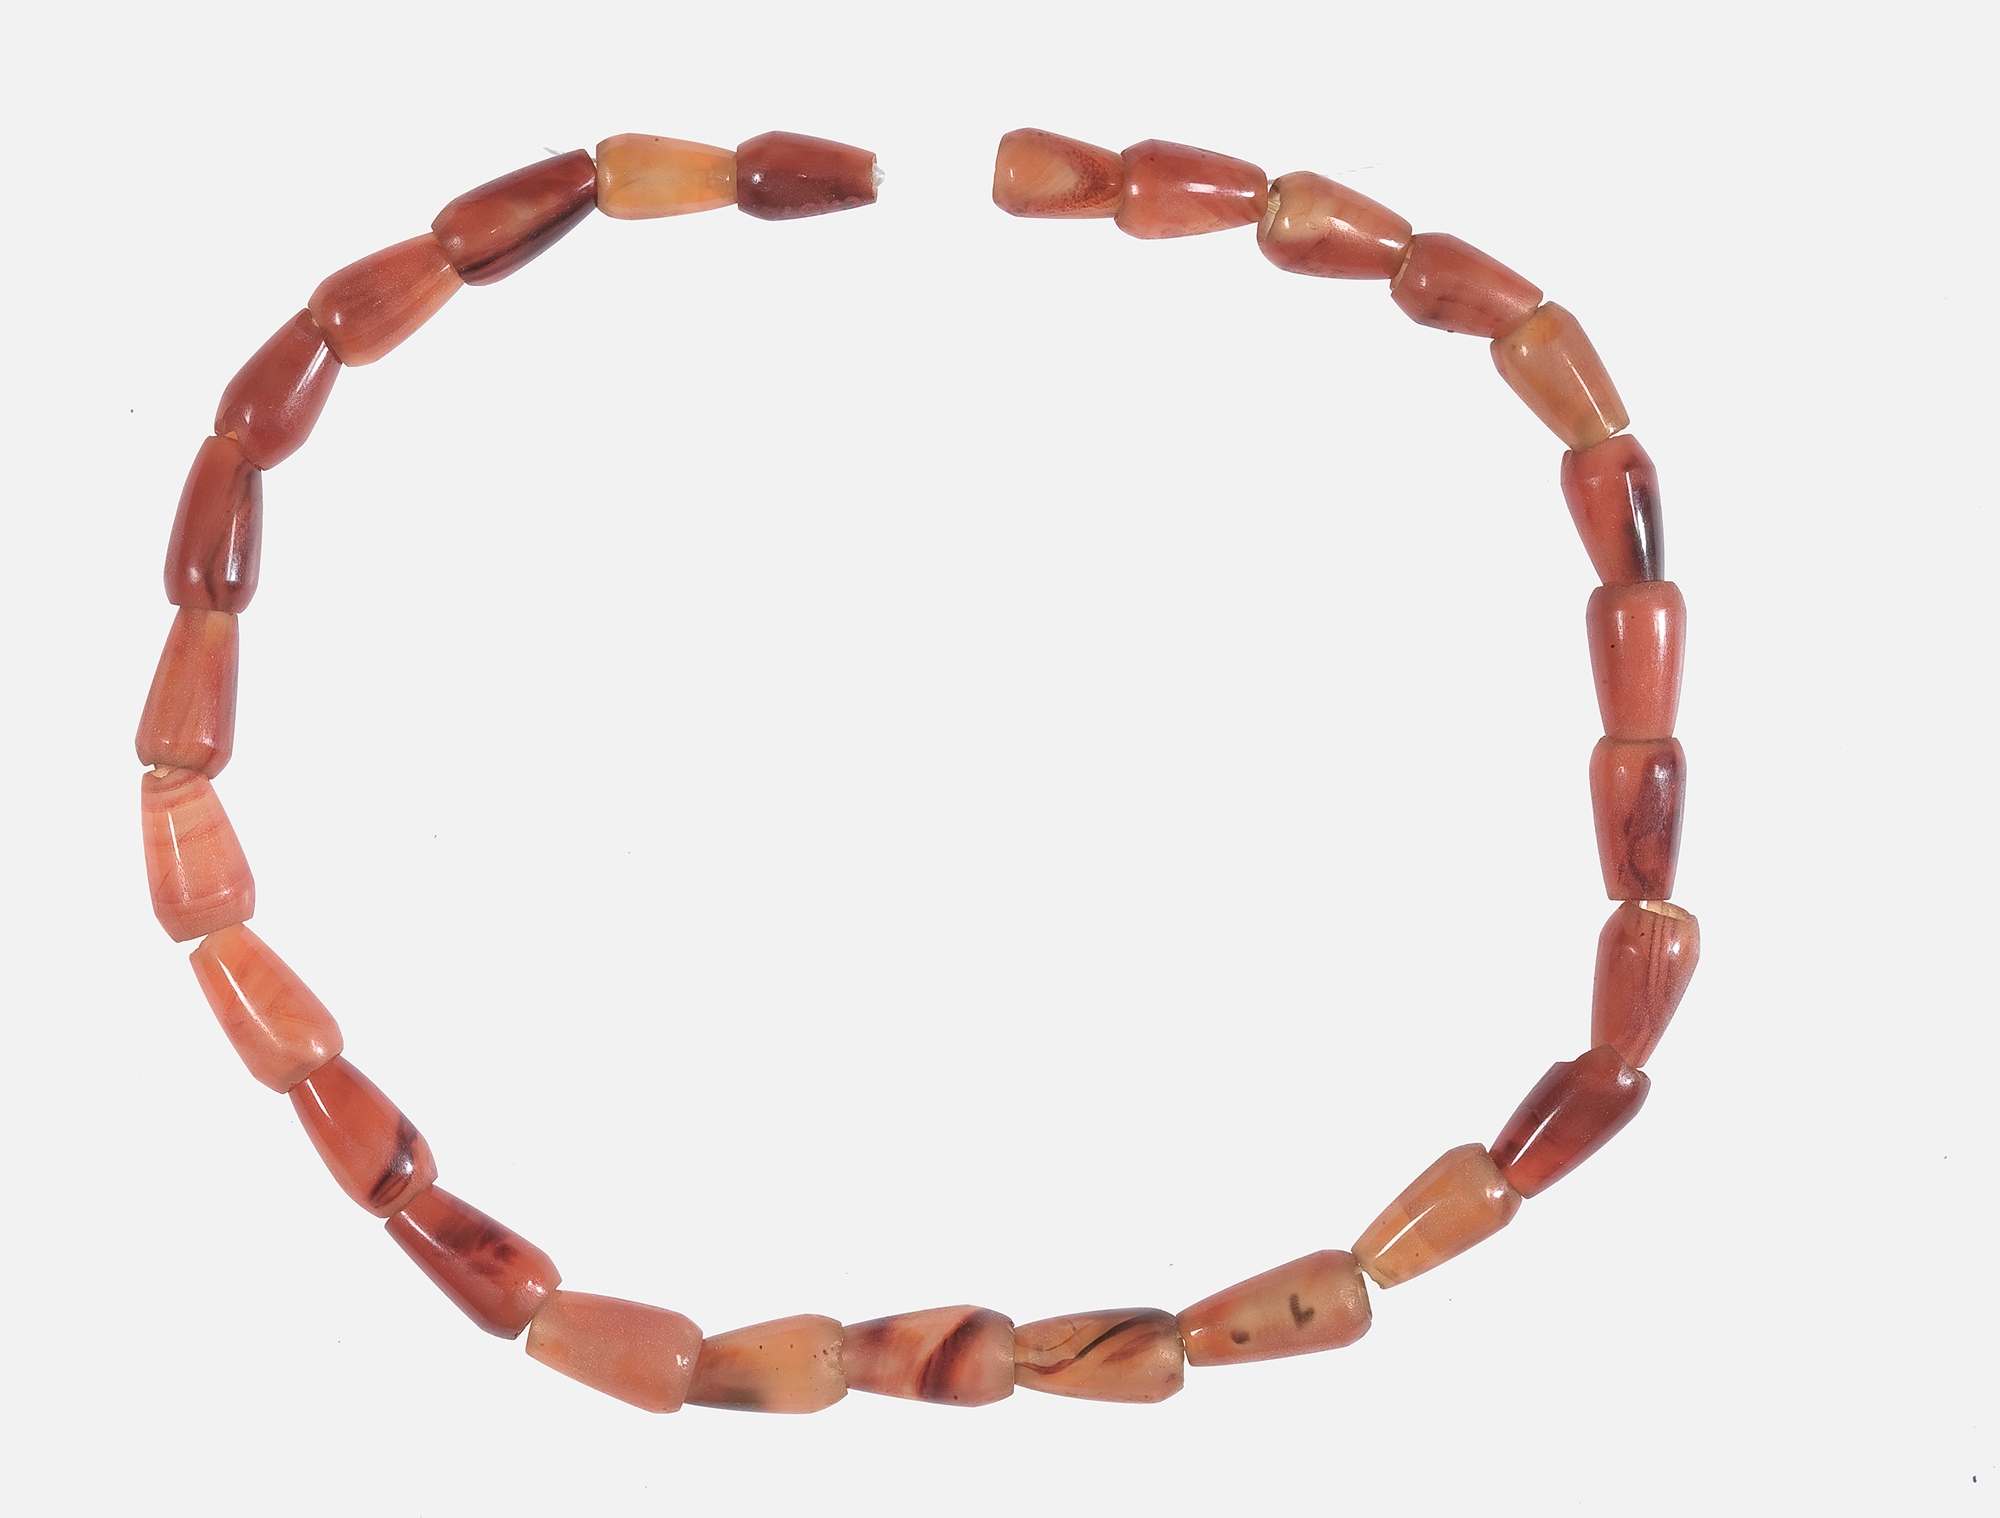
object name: necklace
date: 1991-1450 BCE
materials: gemstone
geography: egypt